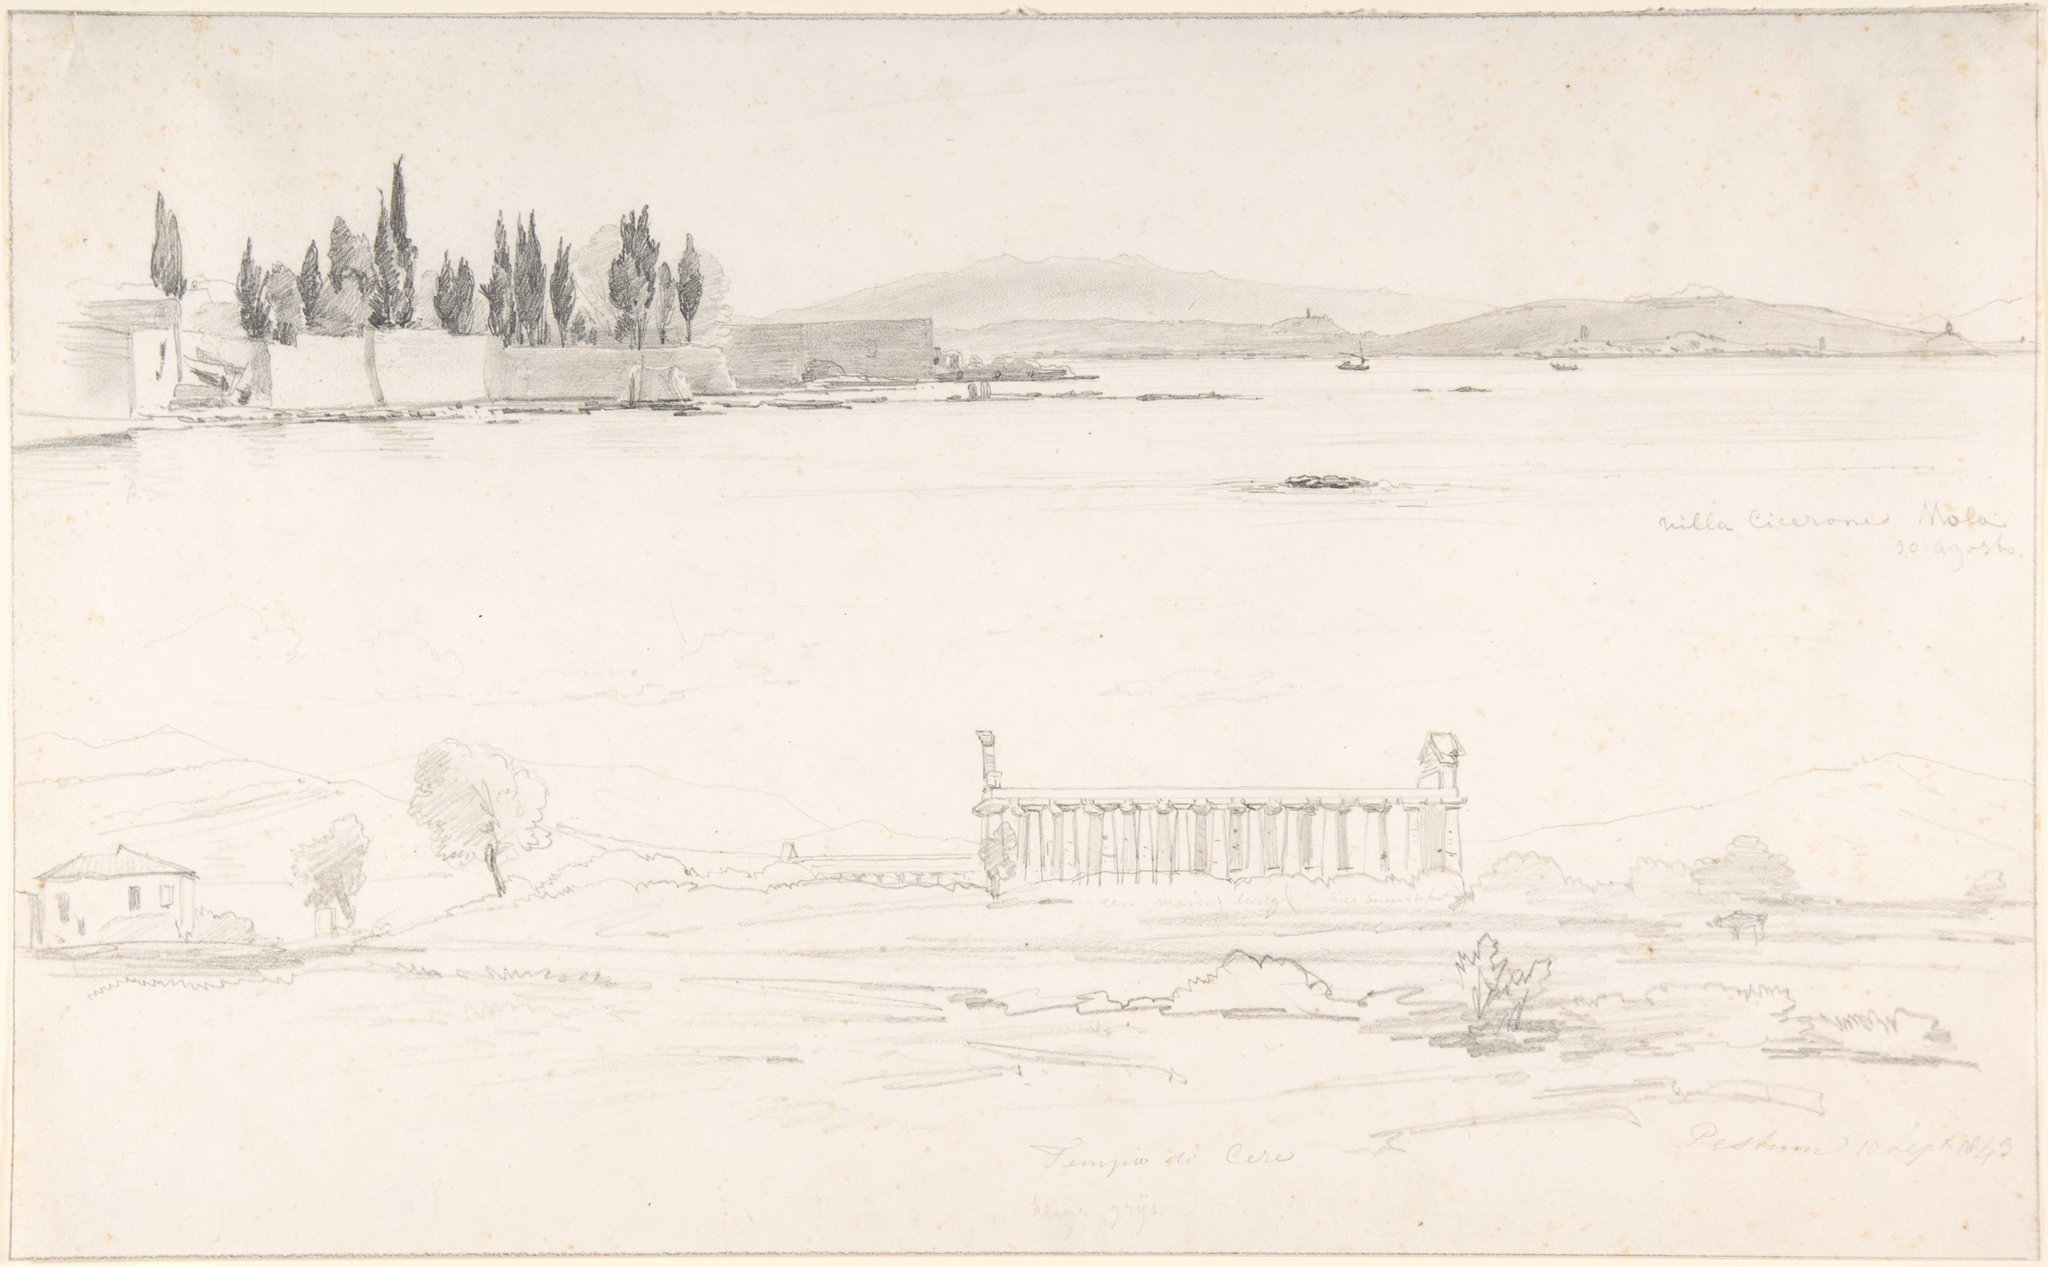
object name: drawing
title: Studies of the Villa Cicerone at the Lago Lucrino near Naples and of the Temple at Paestum (Italy)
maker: pierre louis dubourcq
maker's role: artist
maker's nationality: dutch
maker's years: 1815-1873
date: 1834-1866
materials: graphite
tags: houses,temples,mountains,trees